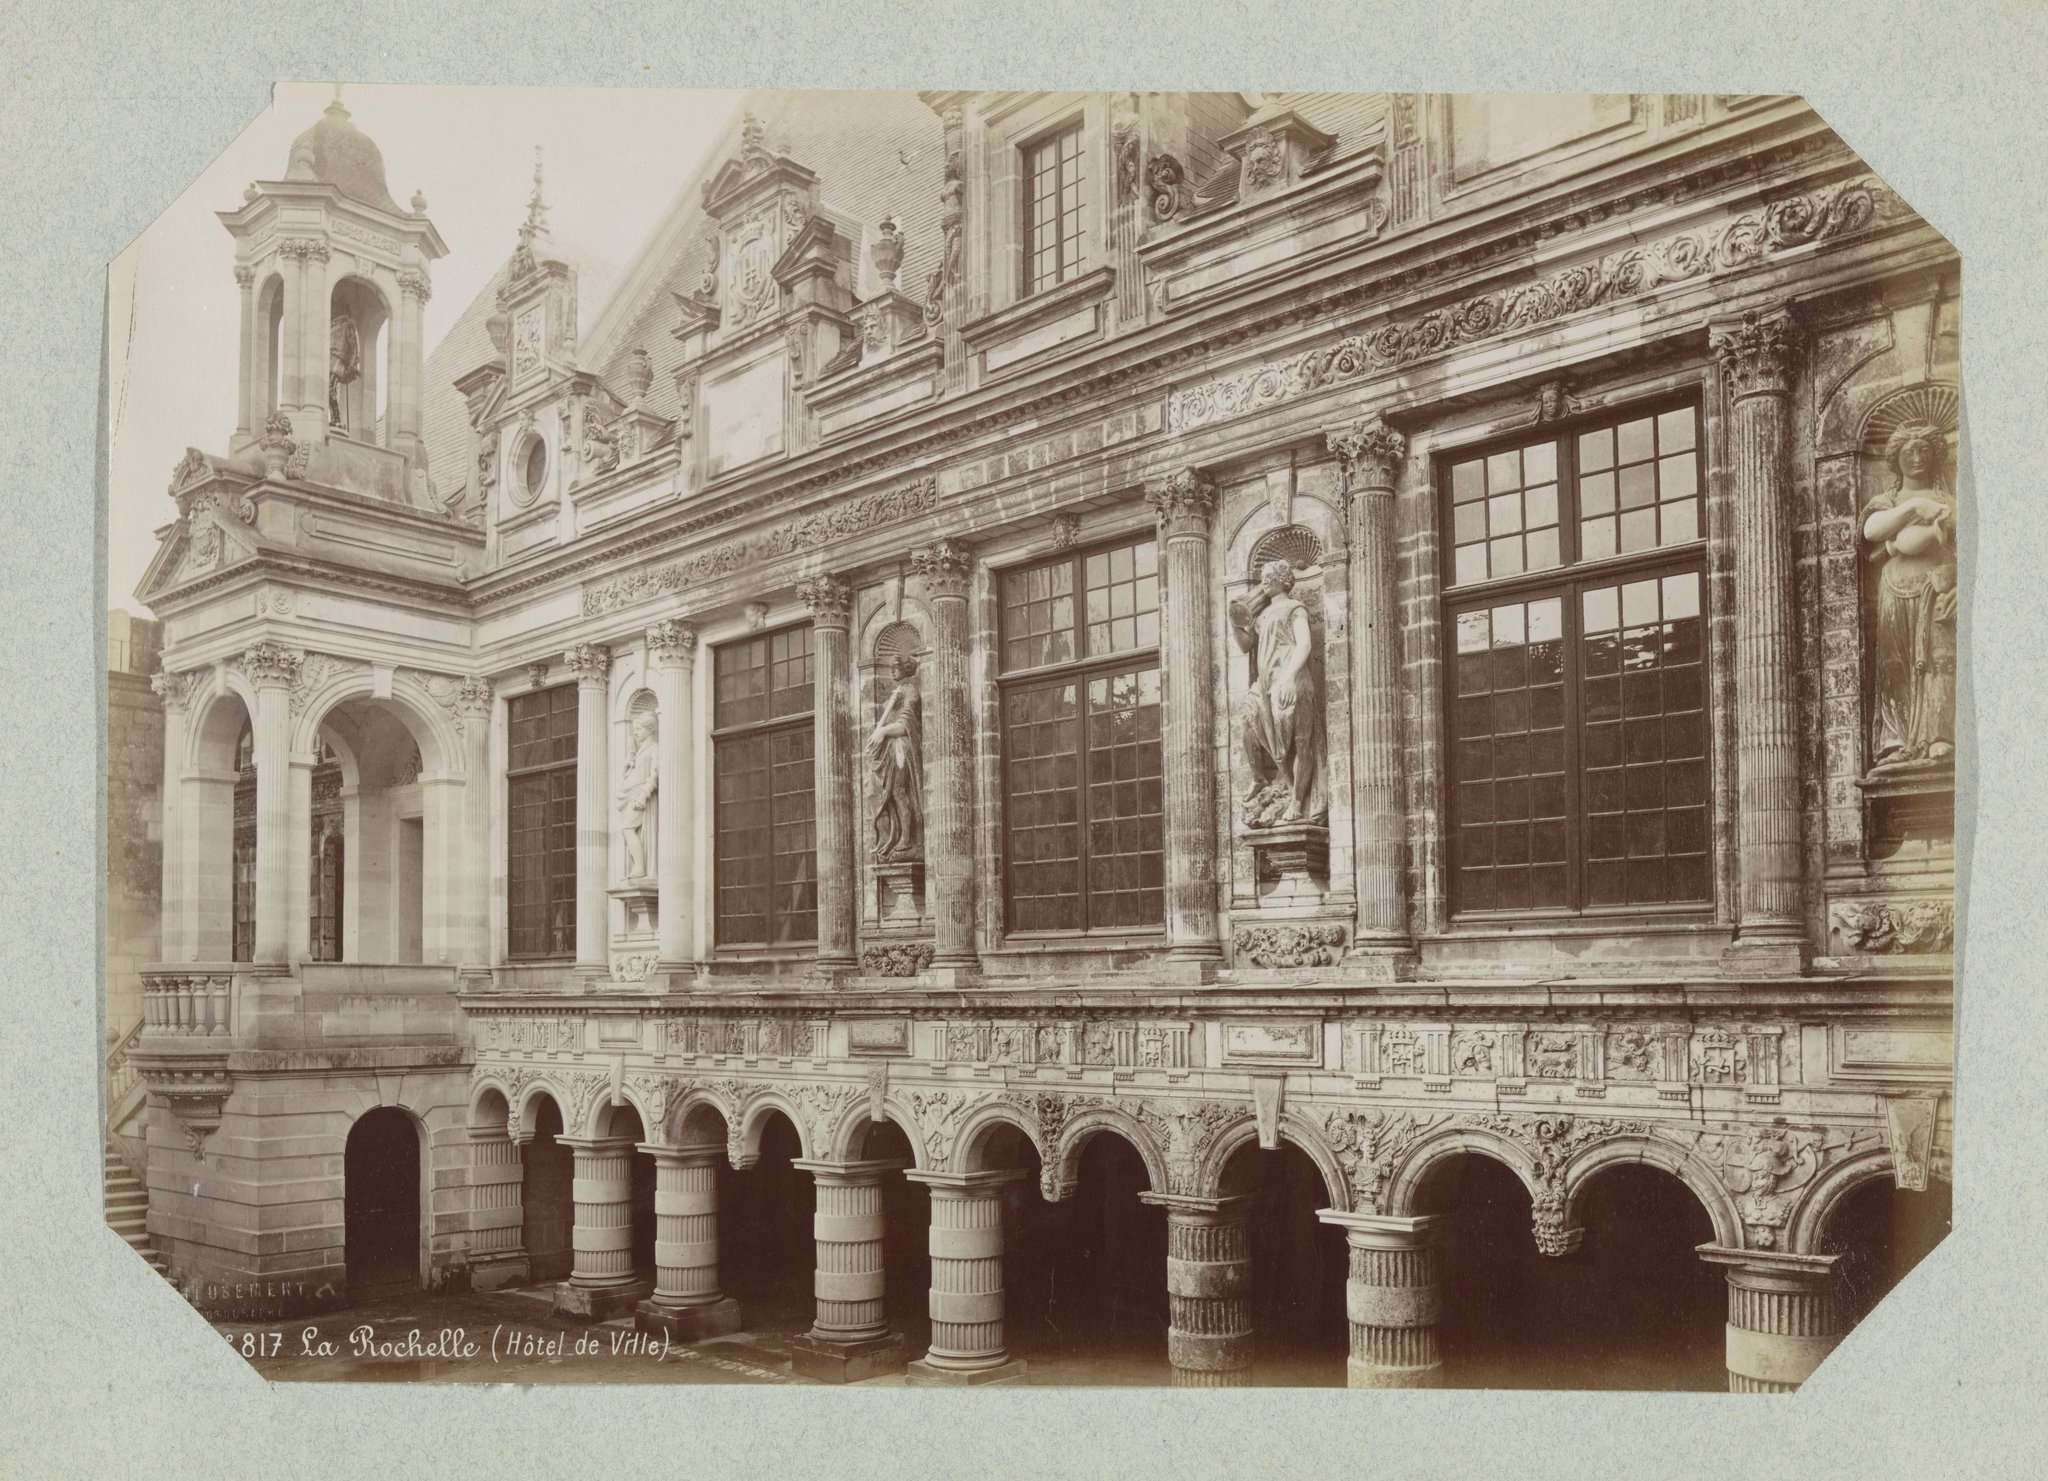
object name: photograph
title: Gevel, toren en zuilengalerij van het stadhuis van La Rochelle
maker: séraphin-médéric mieusement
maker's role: fotograaf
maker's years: 1840-1905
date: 1880-1900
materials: photographic support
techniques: albumen print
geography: la rochelle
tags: colonnade, tower, clock tower ~ monumental adornment, townhall, piece of sculpture, reproduction of a piece of sculpture, façade (of house or building)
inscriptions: number: ‘817’, name: ‘Mieusement photographe’, inscription: ‘Monuments Historiques’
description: Onderdeel van Fotoalbum met opnames van monumenten in Frankrijk.